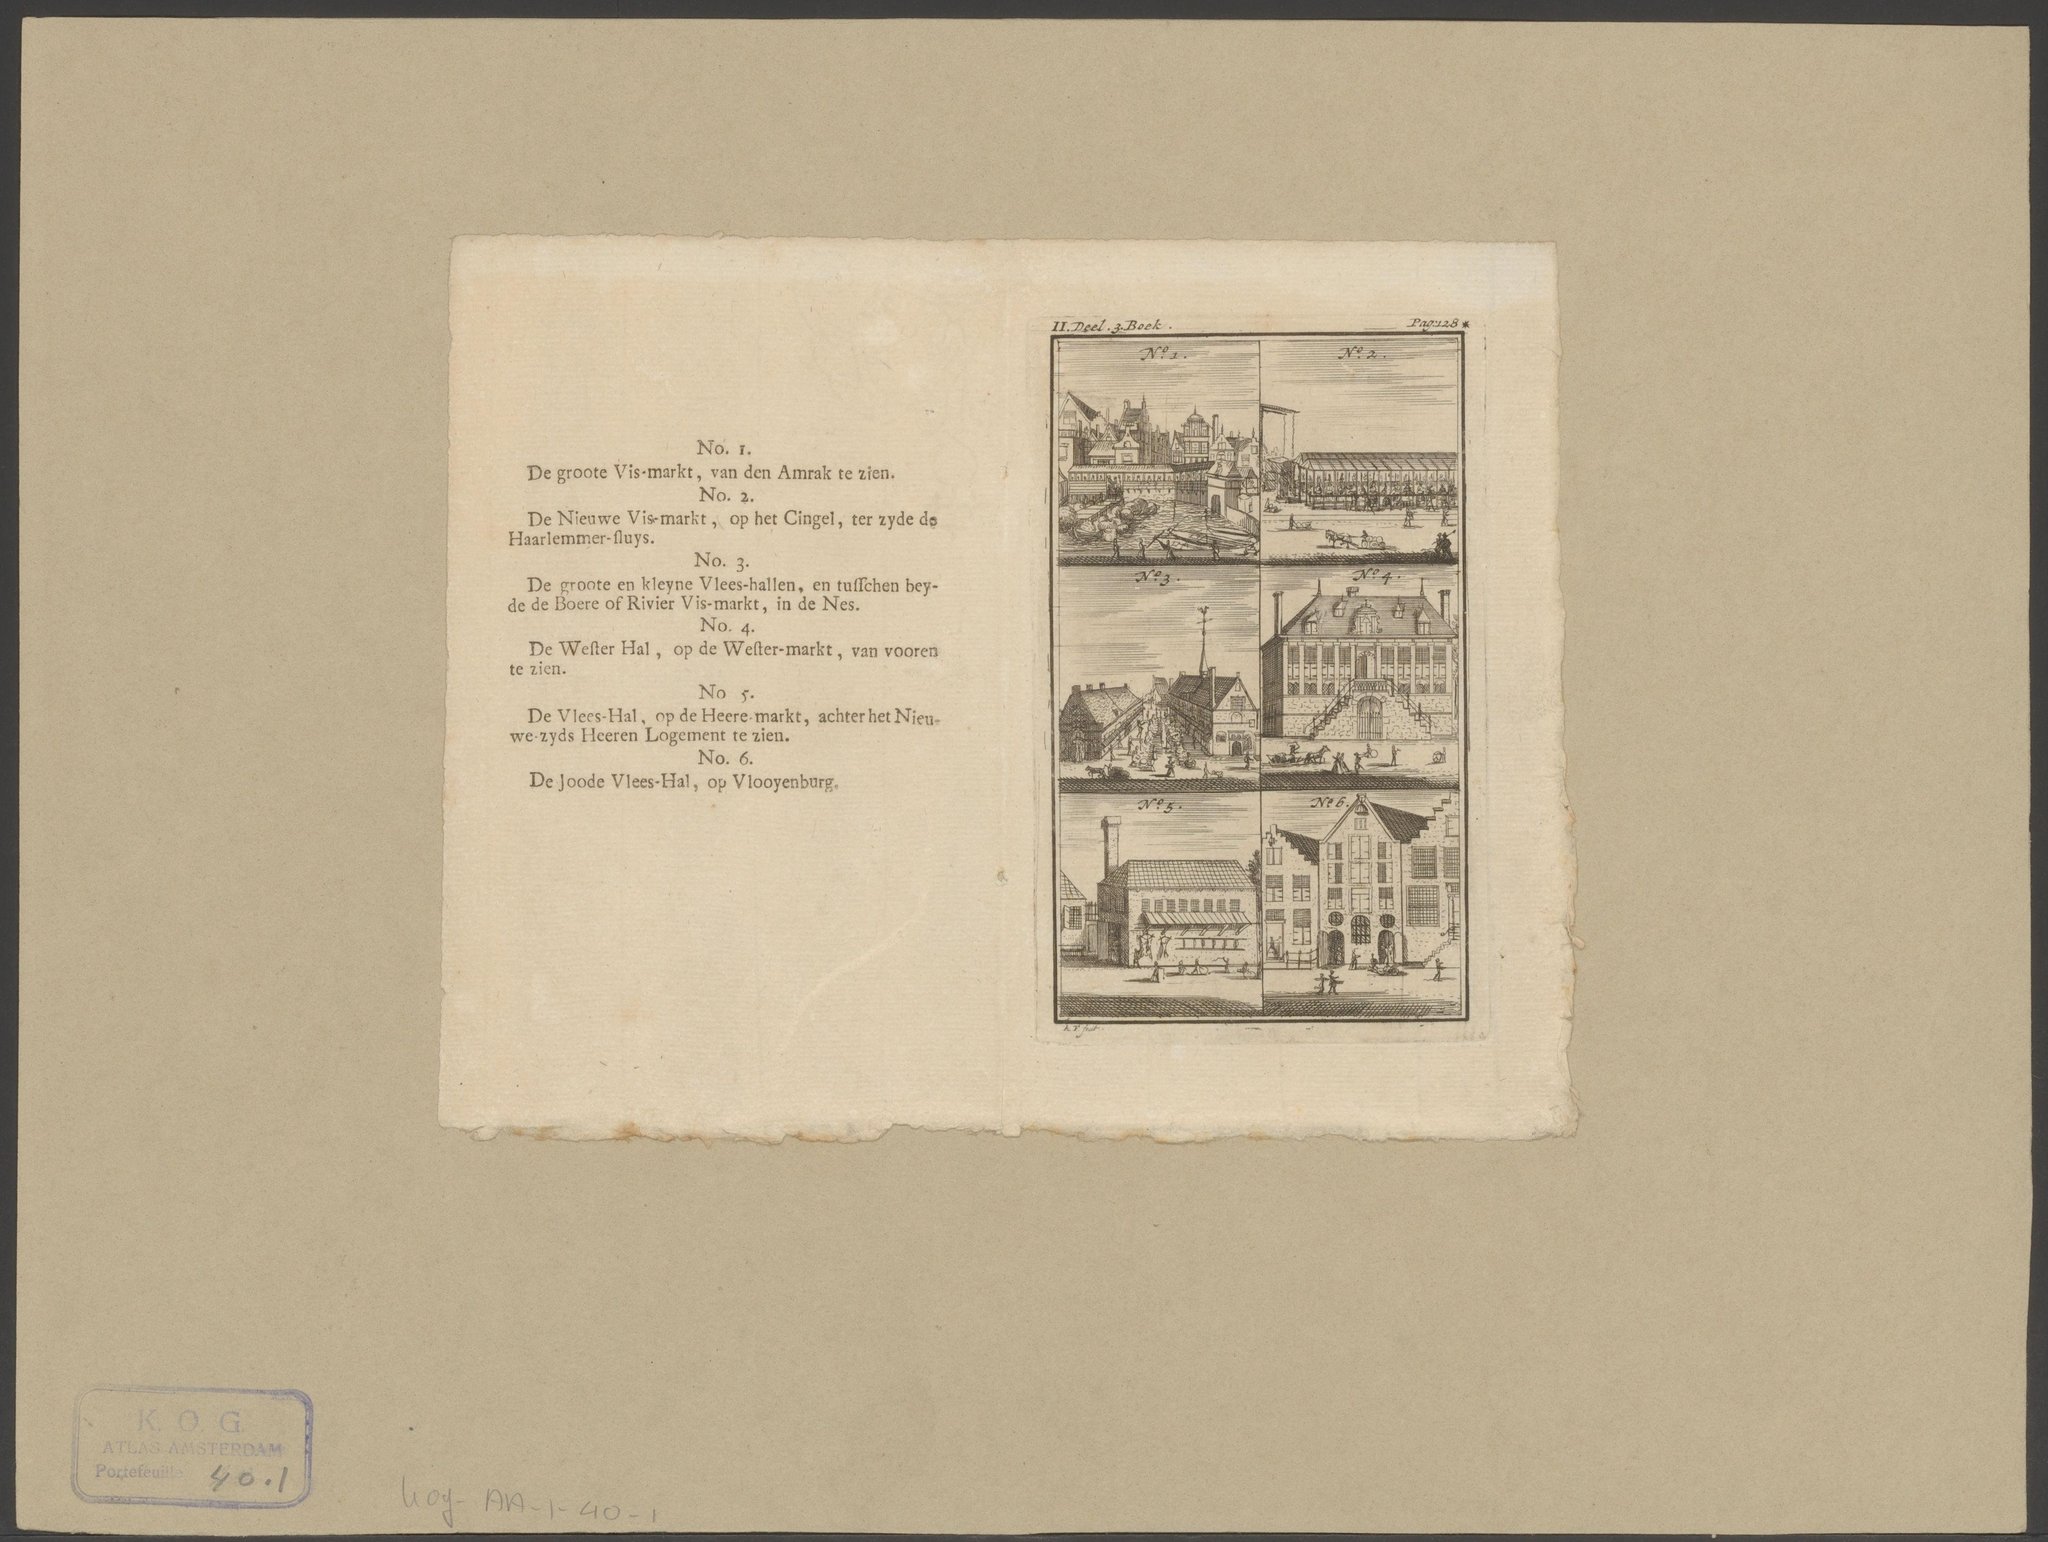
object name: book illustration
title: Zeven verschillende markthallen te Amsterdam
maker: anna folkema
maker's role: draughtsman, print maker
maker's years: 1695-1768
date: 1723-1730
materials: paper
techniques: etching, letterpress printing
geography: amsterdam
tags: city-view, and landscape with man-made constructions (+ city(-scape) with figures, staffage), market-hall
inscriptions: collector's mark: Lugt 1641b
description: Individuele voorstellingen van de Grote Vismarkt, Nieuwe Vismarkt, Grote Vleeshal, Kleine Vleeshal, Westerhal, Vleeshal op de Herenmarkt en Joodse Vleeshal, genummerd van N° 1 tot en met N° 6. Bovenaan gemerkt: II. Deel. 3. Boek. / Pag: 128*. Onderwerpsrubriek binnen de Atlas Amsterdam: Handel en Zeevaart: Verzamelbladen.